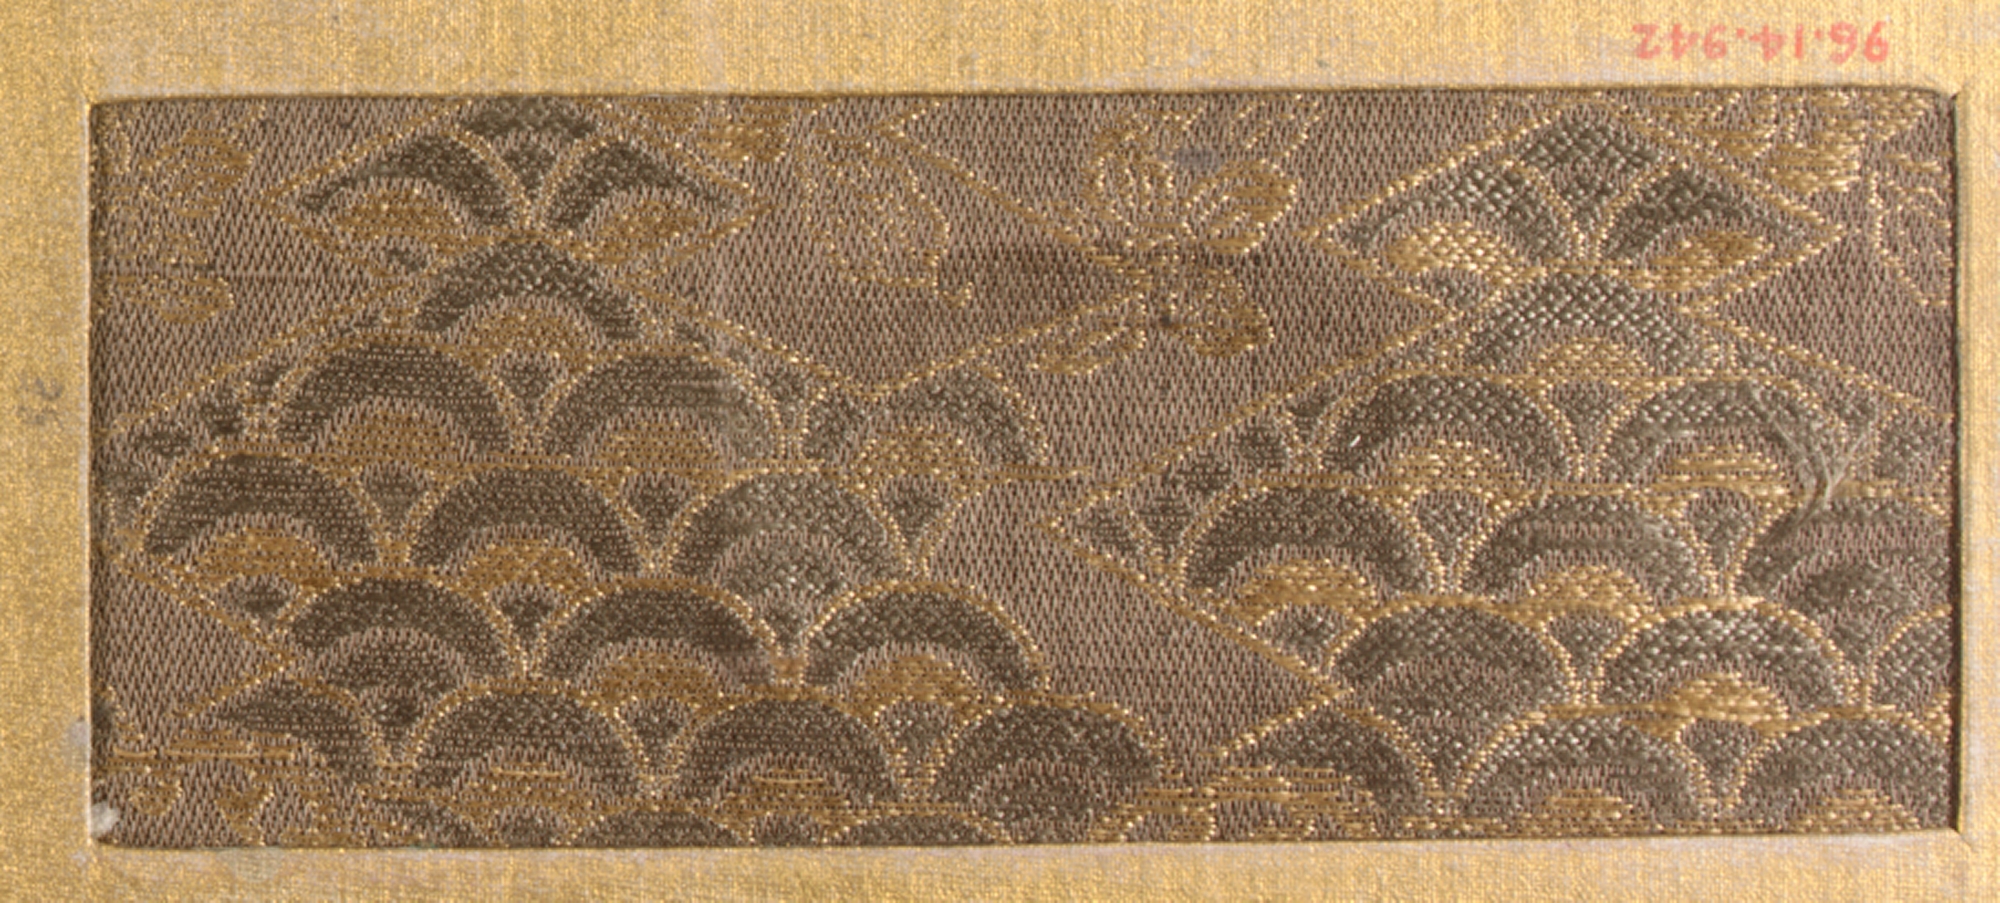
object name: piece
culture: japanese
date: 1701-1900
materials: silk